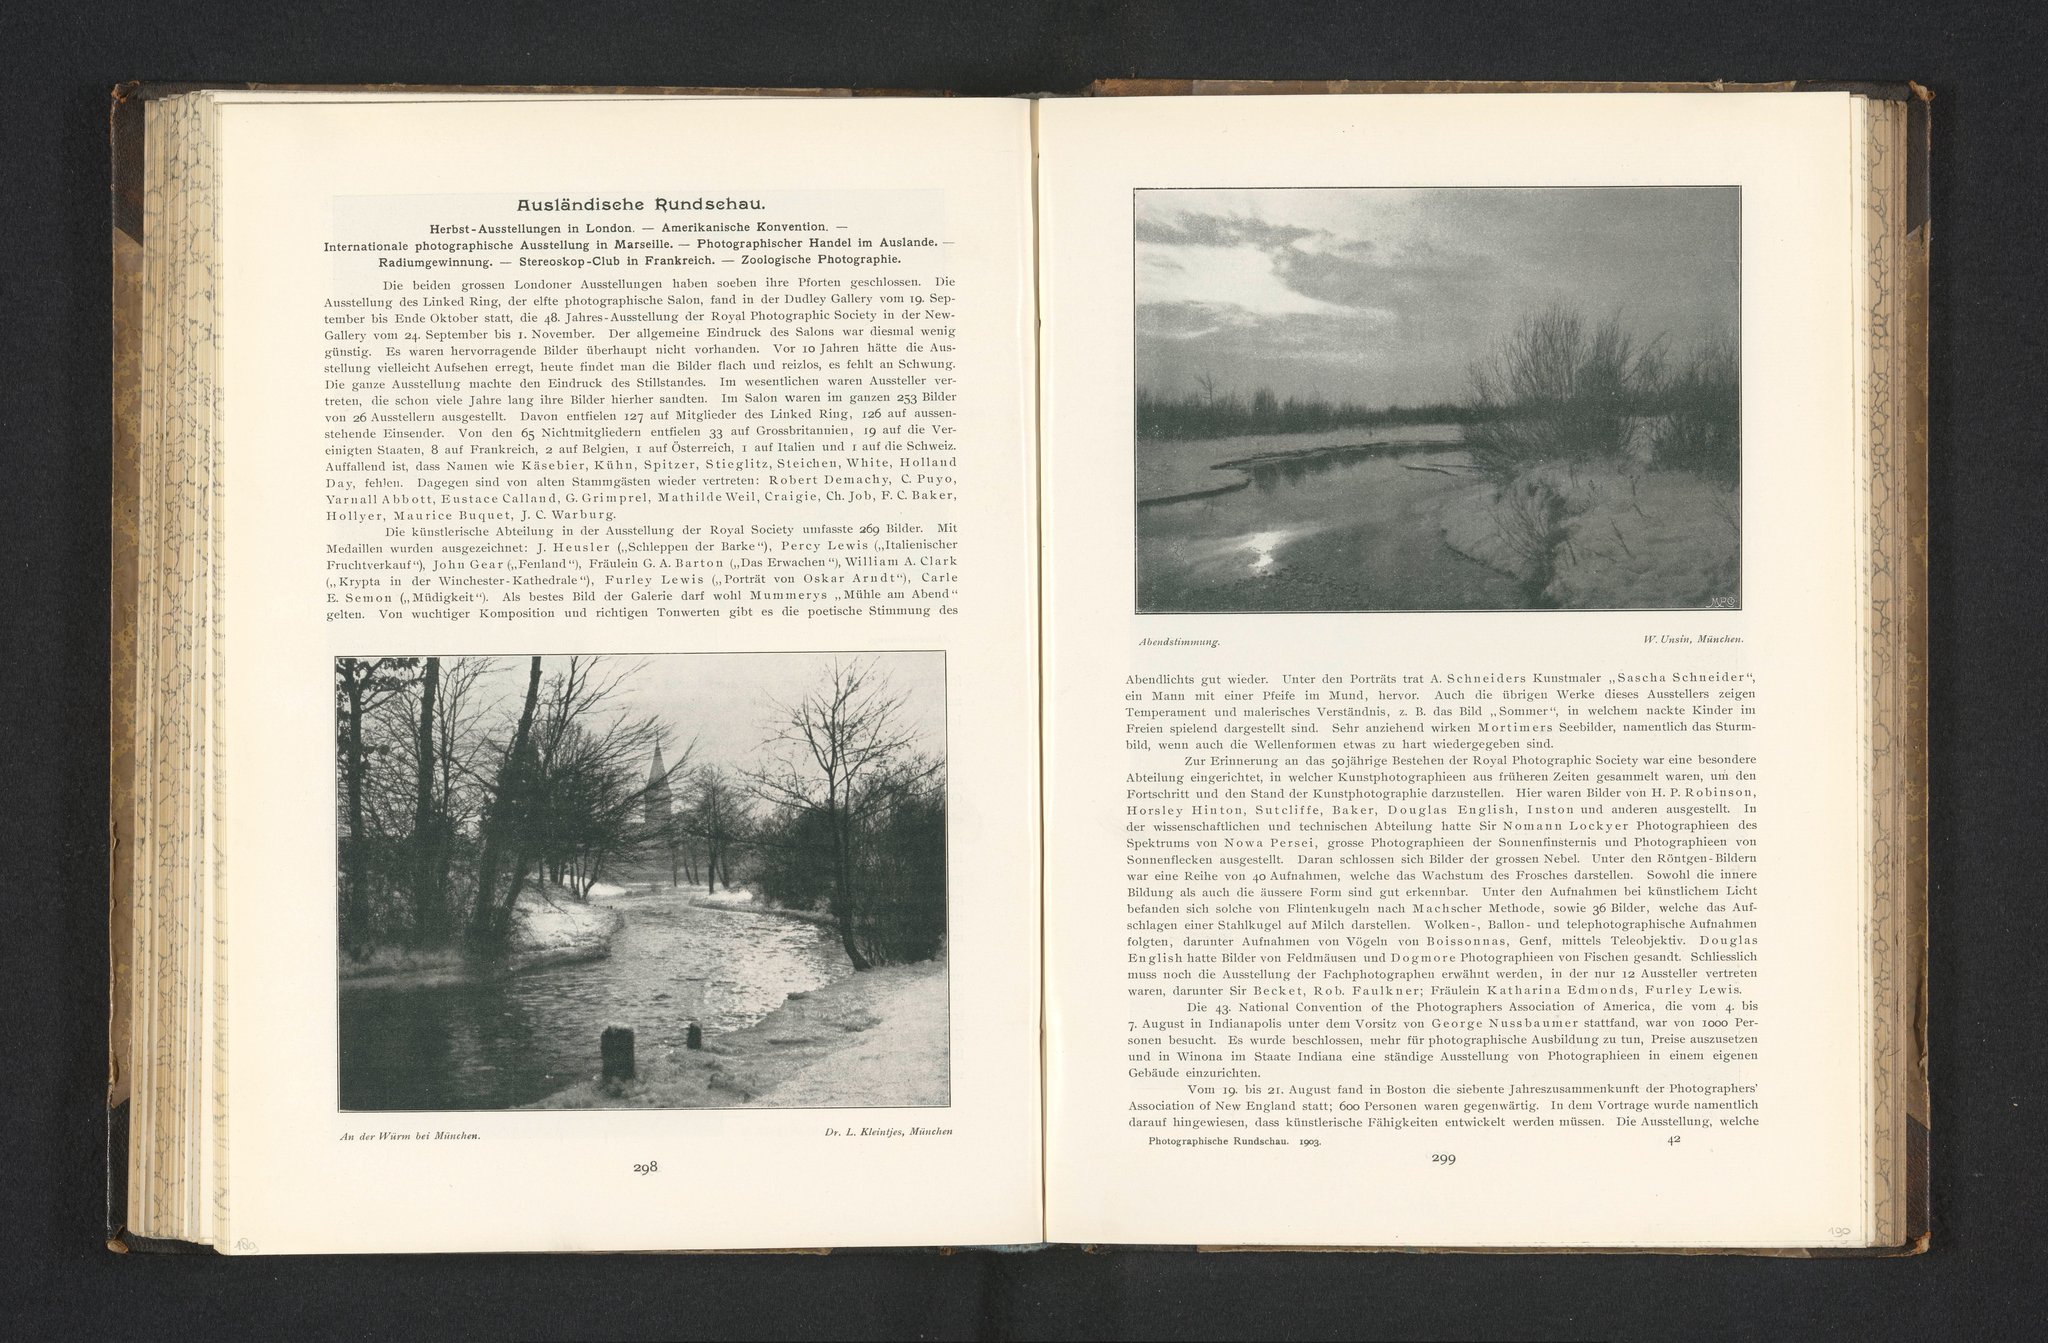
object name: page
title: Landschap in de avondschemer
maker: w. unsin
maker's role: fotograaf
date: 1898-1903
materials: paper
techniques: autotype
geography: berlin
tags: dusk, evening twilight, landscapes